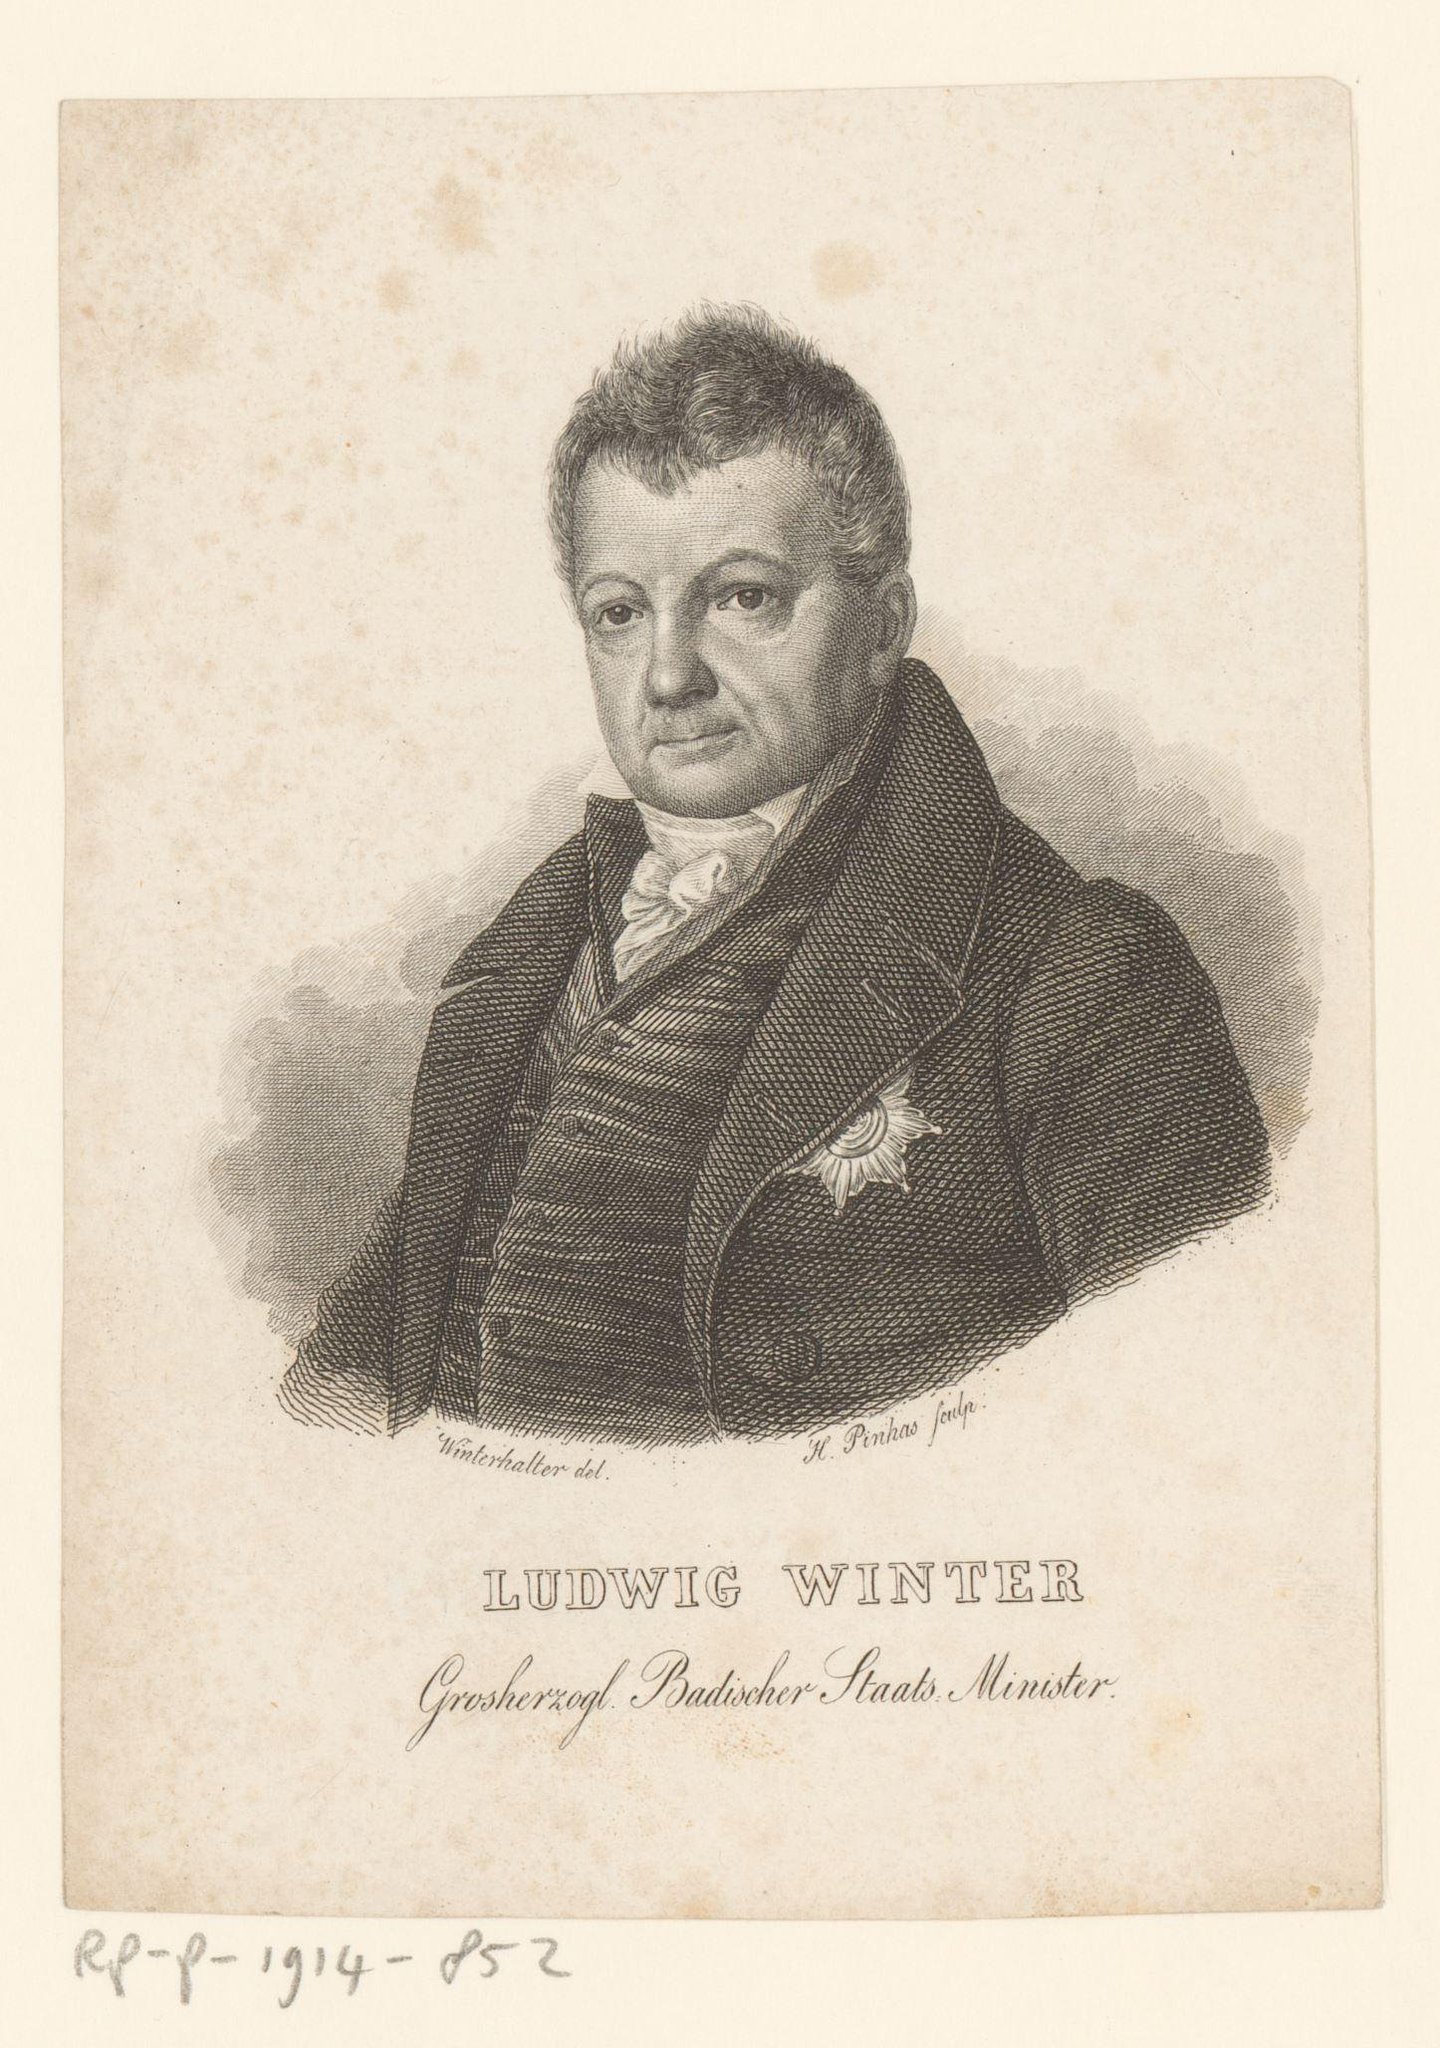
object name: print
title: Portret van Ludwig Georg Winter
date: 1805-1844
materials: paper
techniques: engraving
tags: knighthood order (red eagle order), historical persons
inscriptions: collector's mark: Lugt 2228